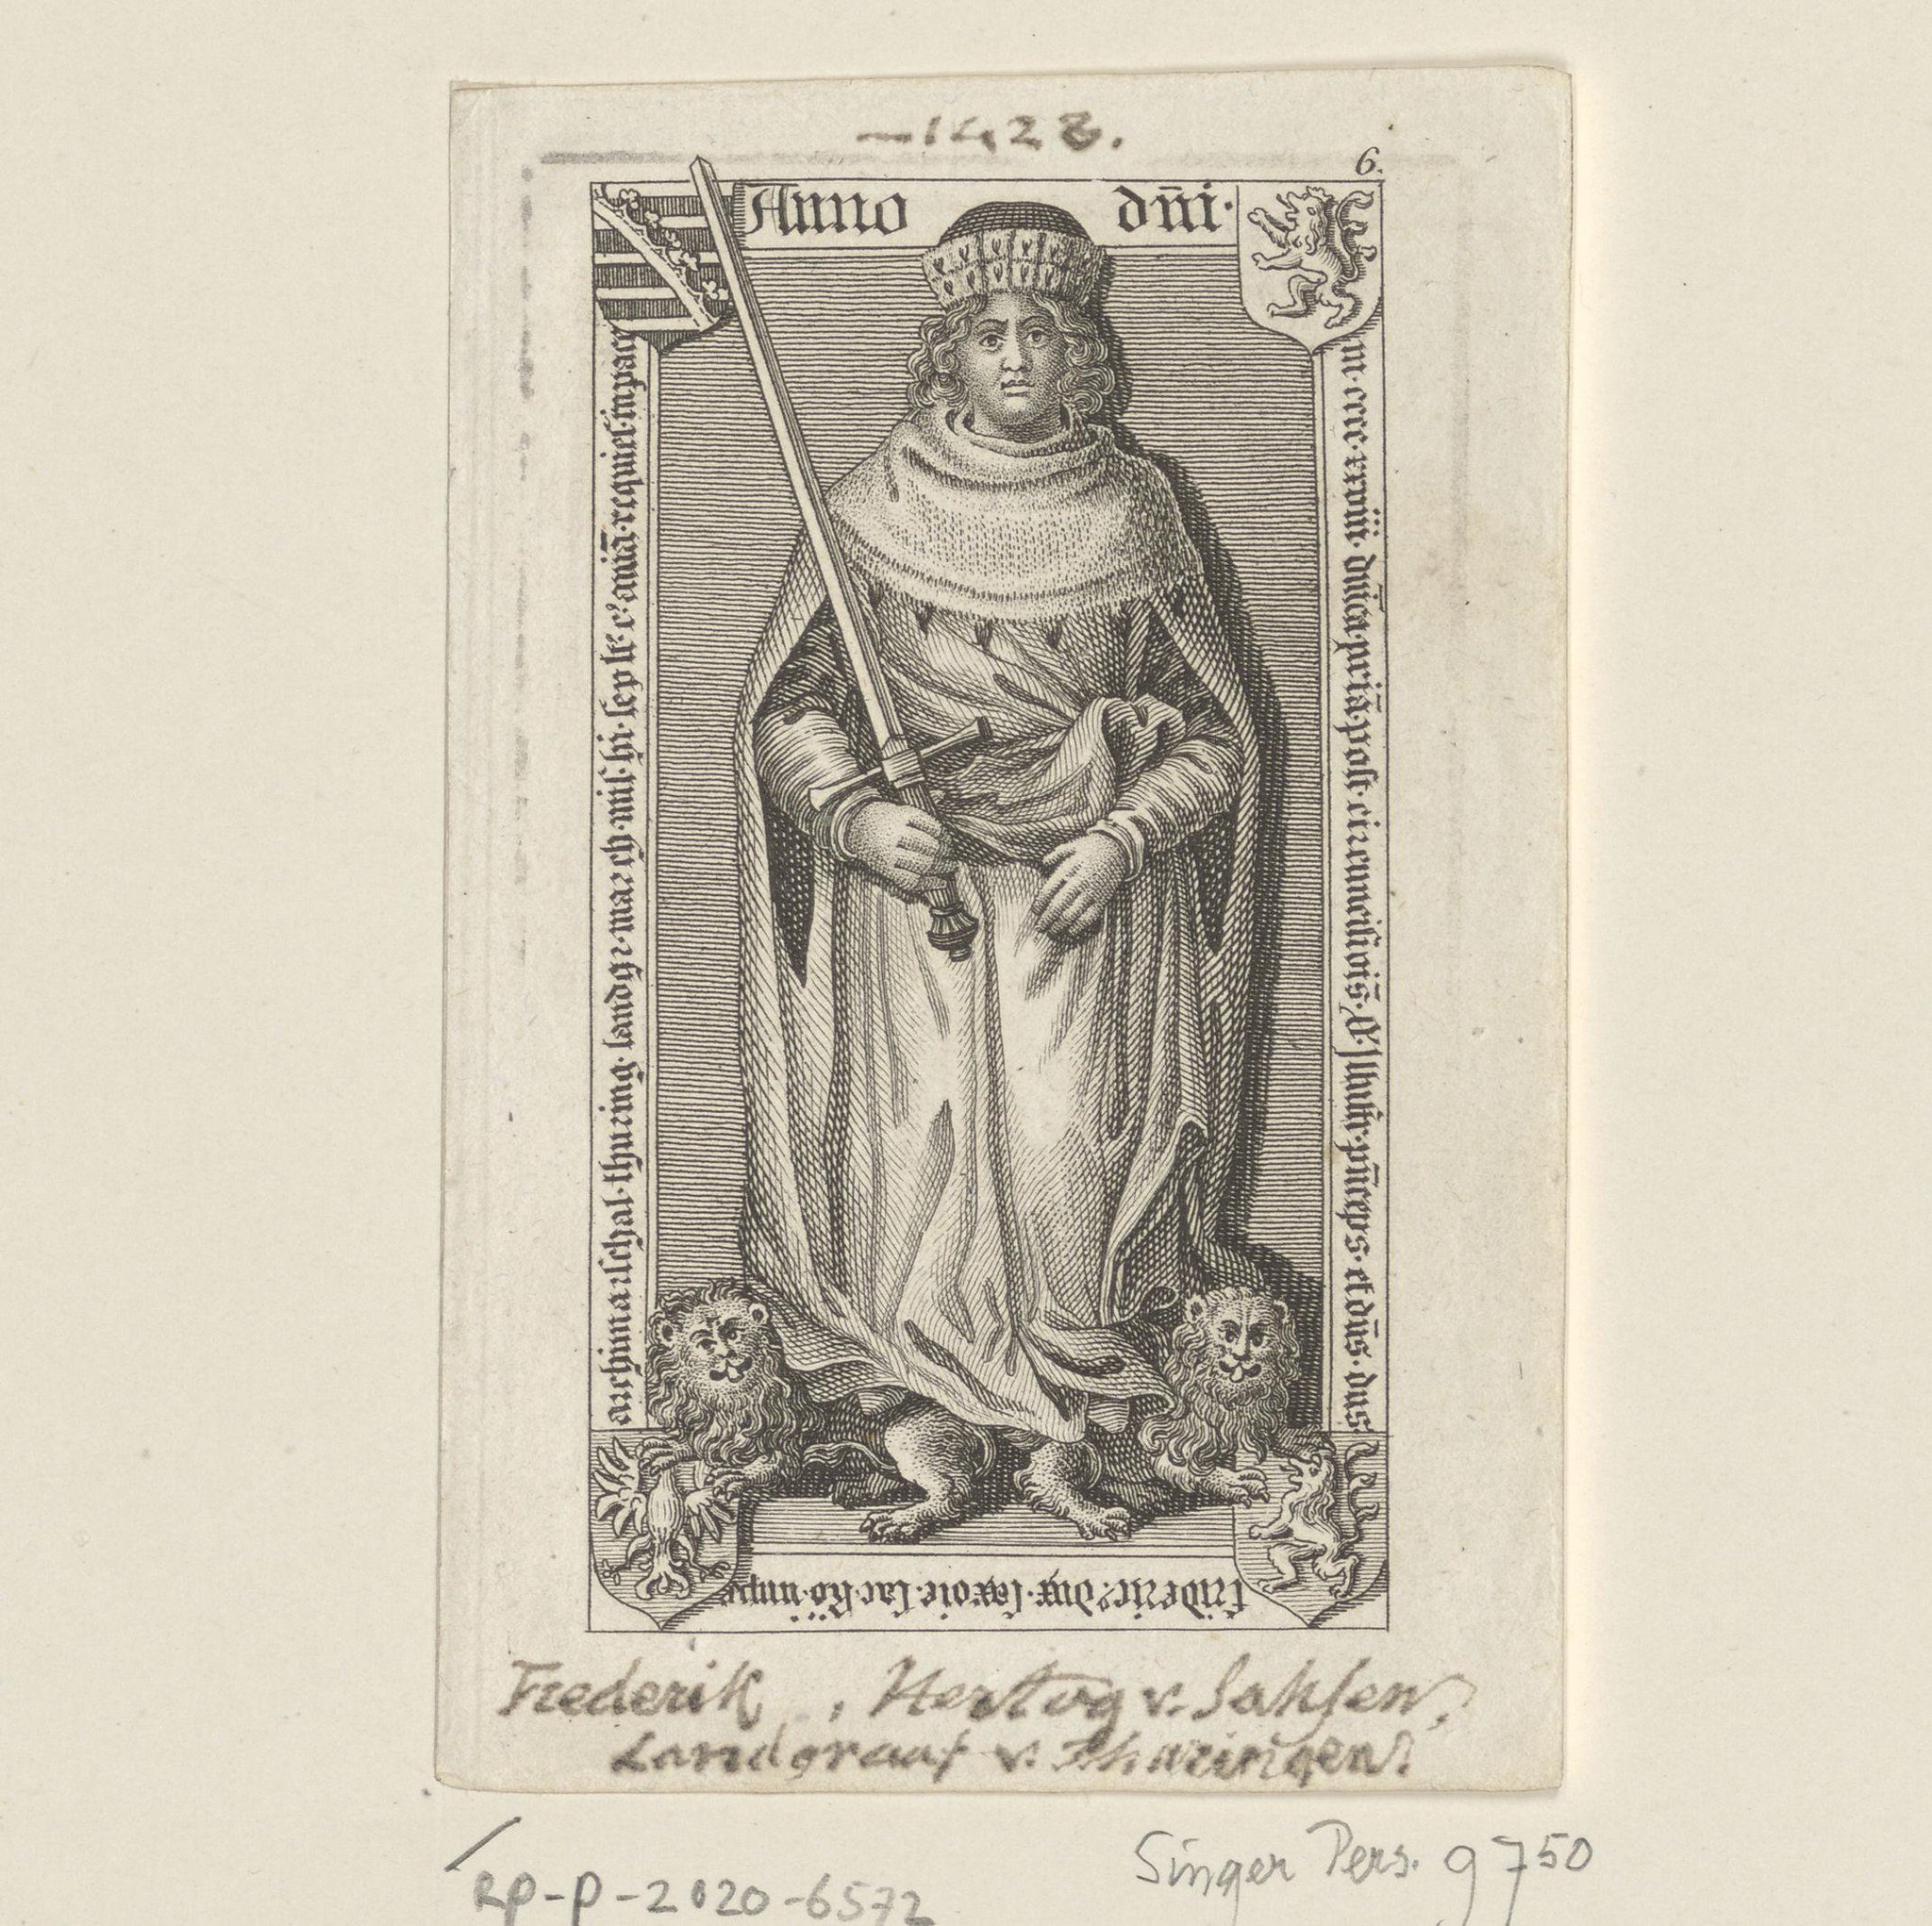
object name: print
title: Graftombe van Frederik I van Saksen in de Dom van Meißen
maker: Anonymous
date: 1700-1799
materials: paper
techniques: etching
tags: coat of arms (symbol of sovereignty), historical persons, hacking and thrusting weapons: sword, grave, tomb, ruler, sovereign, beasts of prey, predatory animals: lion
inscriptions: inscription: ‘Frederik, Hertog v. Saksen,/ Landgraaf v. Thuringen’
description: De graftombe van bovenaf gezien. Rechtsboven genummerd: 6.